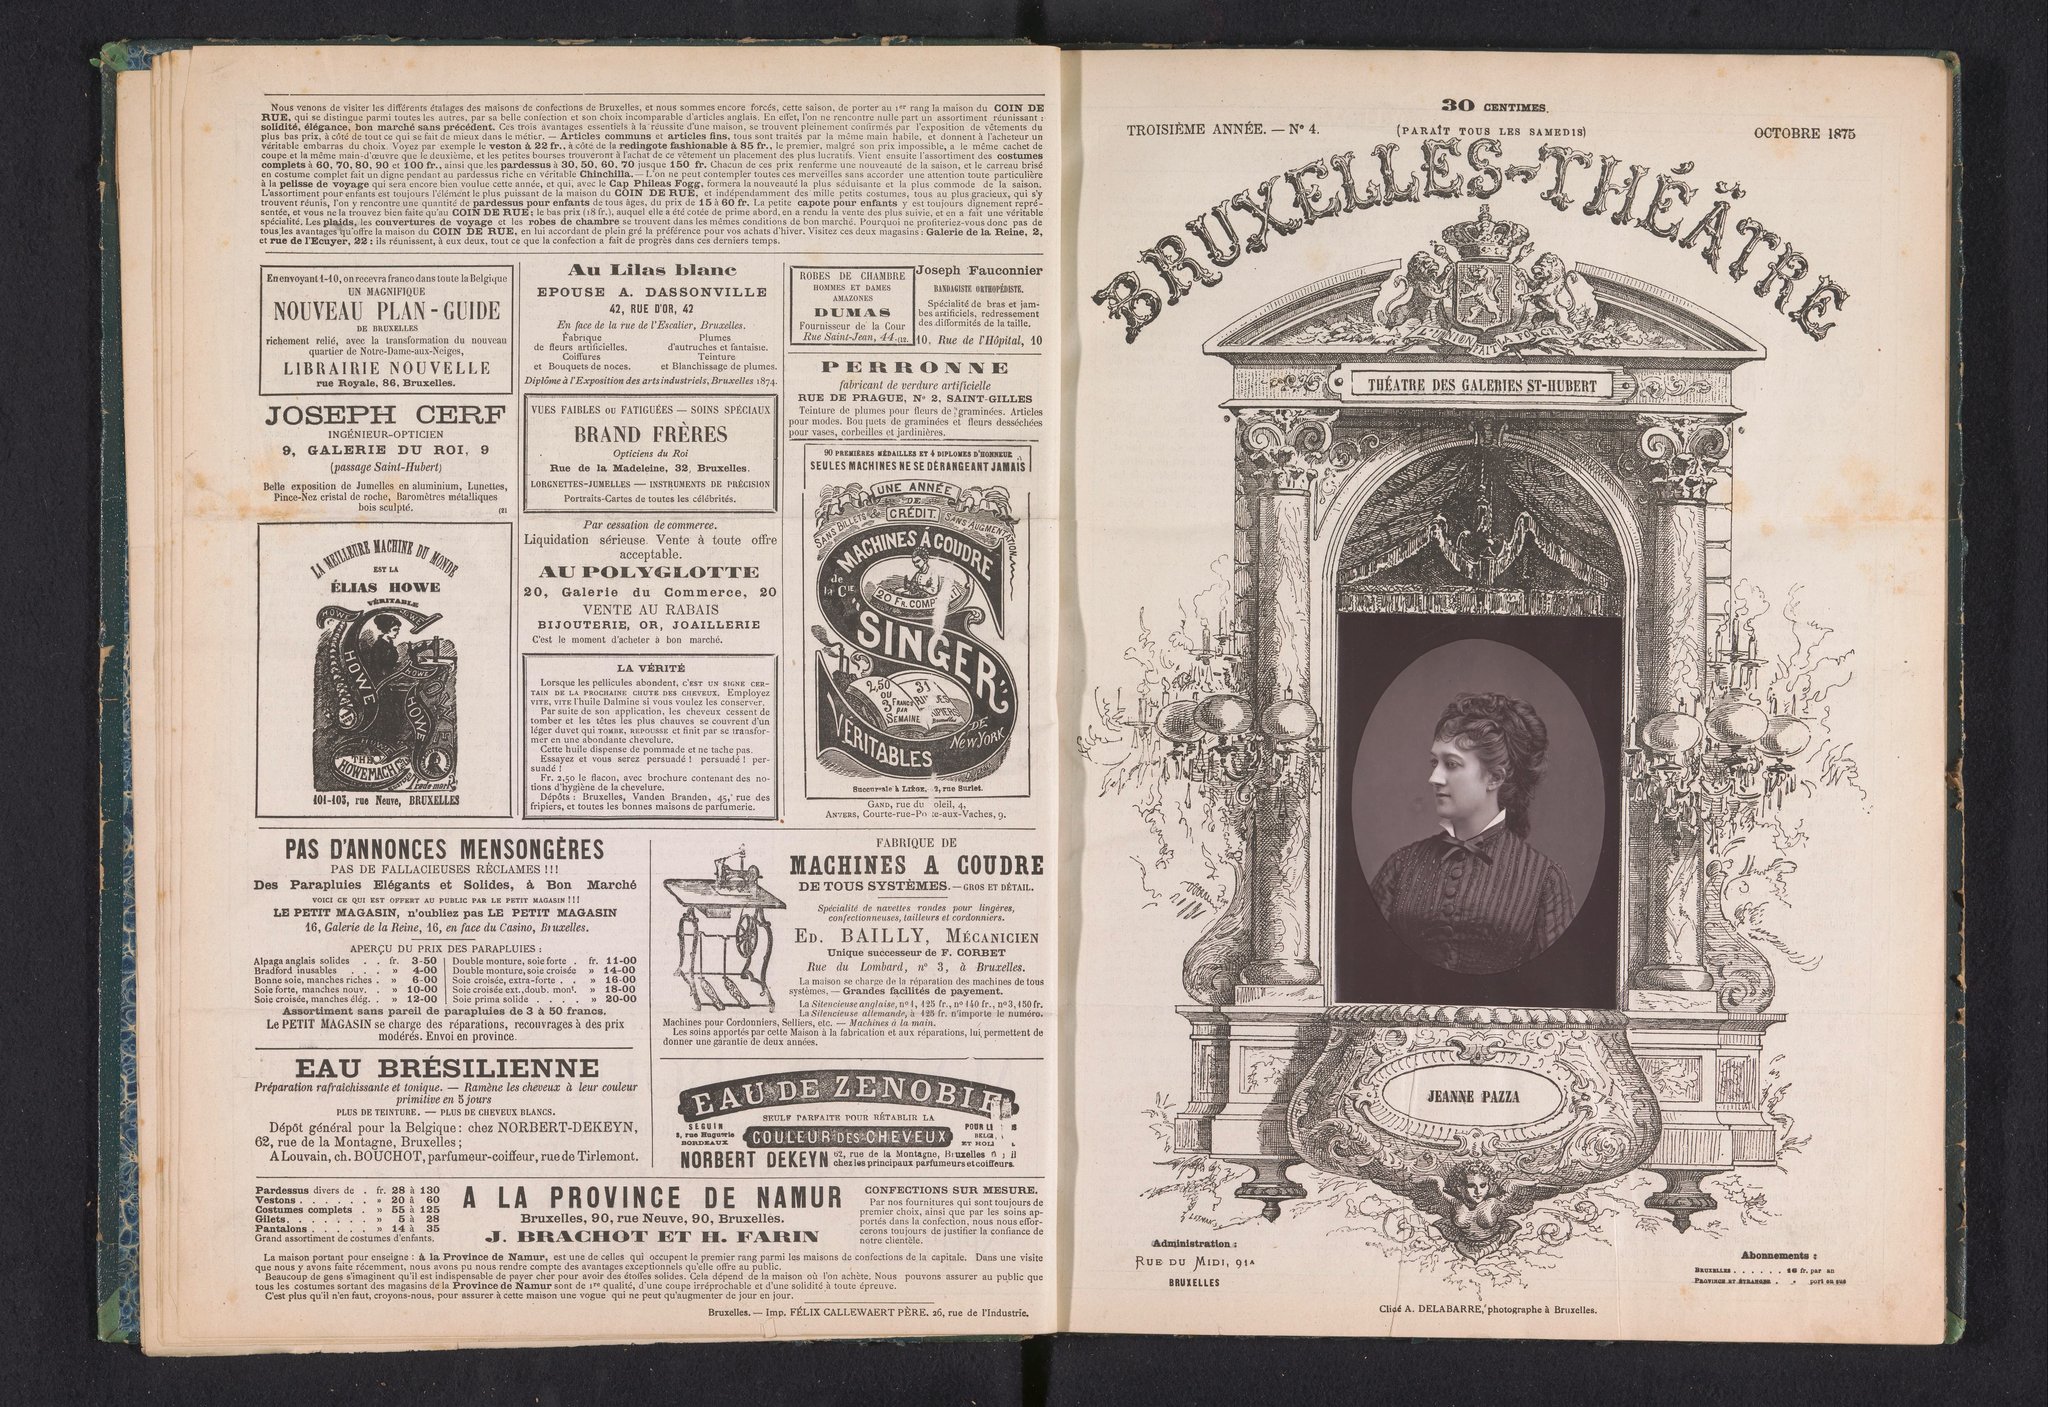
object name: page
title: Jeanne Pazza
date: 1870-1875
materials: paper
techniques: woodburytype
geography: brussels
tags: portrait of actor, actress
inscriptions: number: ‘No 4.’